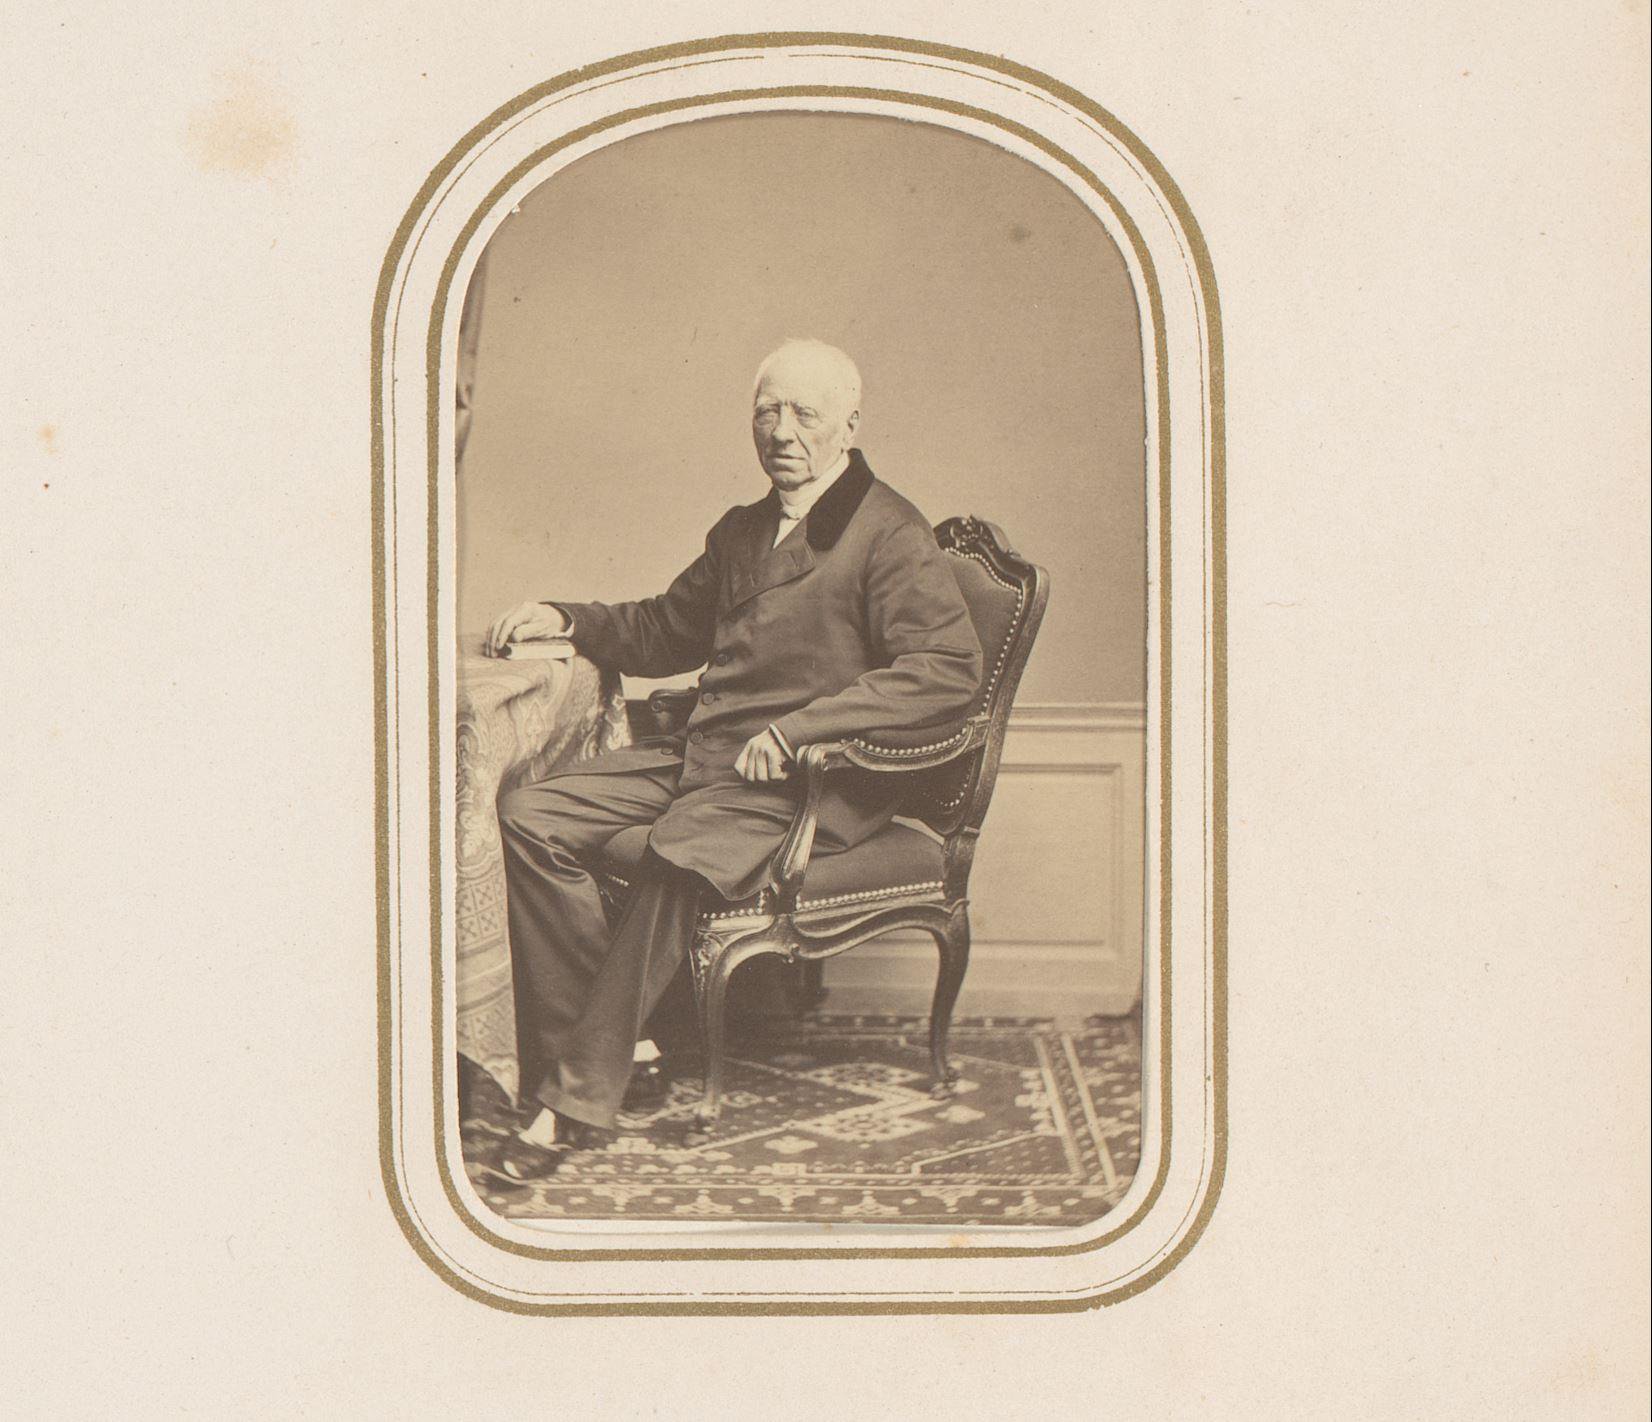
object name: carte de visite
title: Portret van een zittende man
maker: nicolas claude persus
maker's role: fotograaf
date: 1850-1890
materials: cardboard, photographic support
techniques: albumen print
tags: sitting figure, adult man, historical persons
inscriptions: inscription: ‘Persus/ Photographe/ 8, Rue Cassette/ au Rez-de-Chaussée/ Paris’